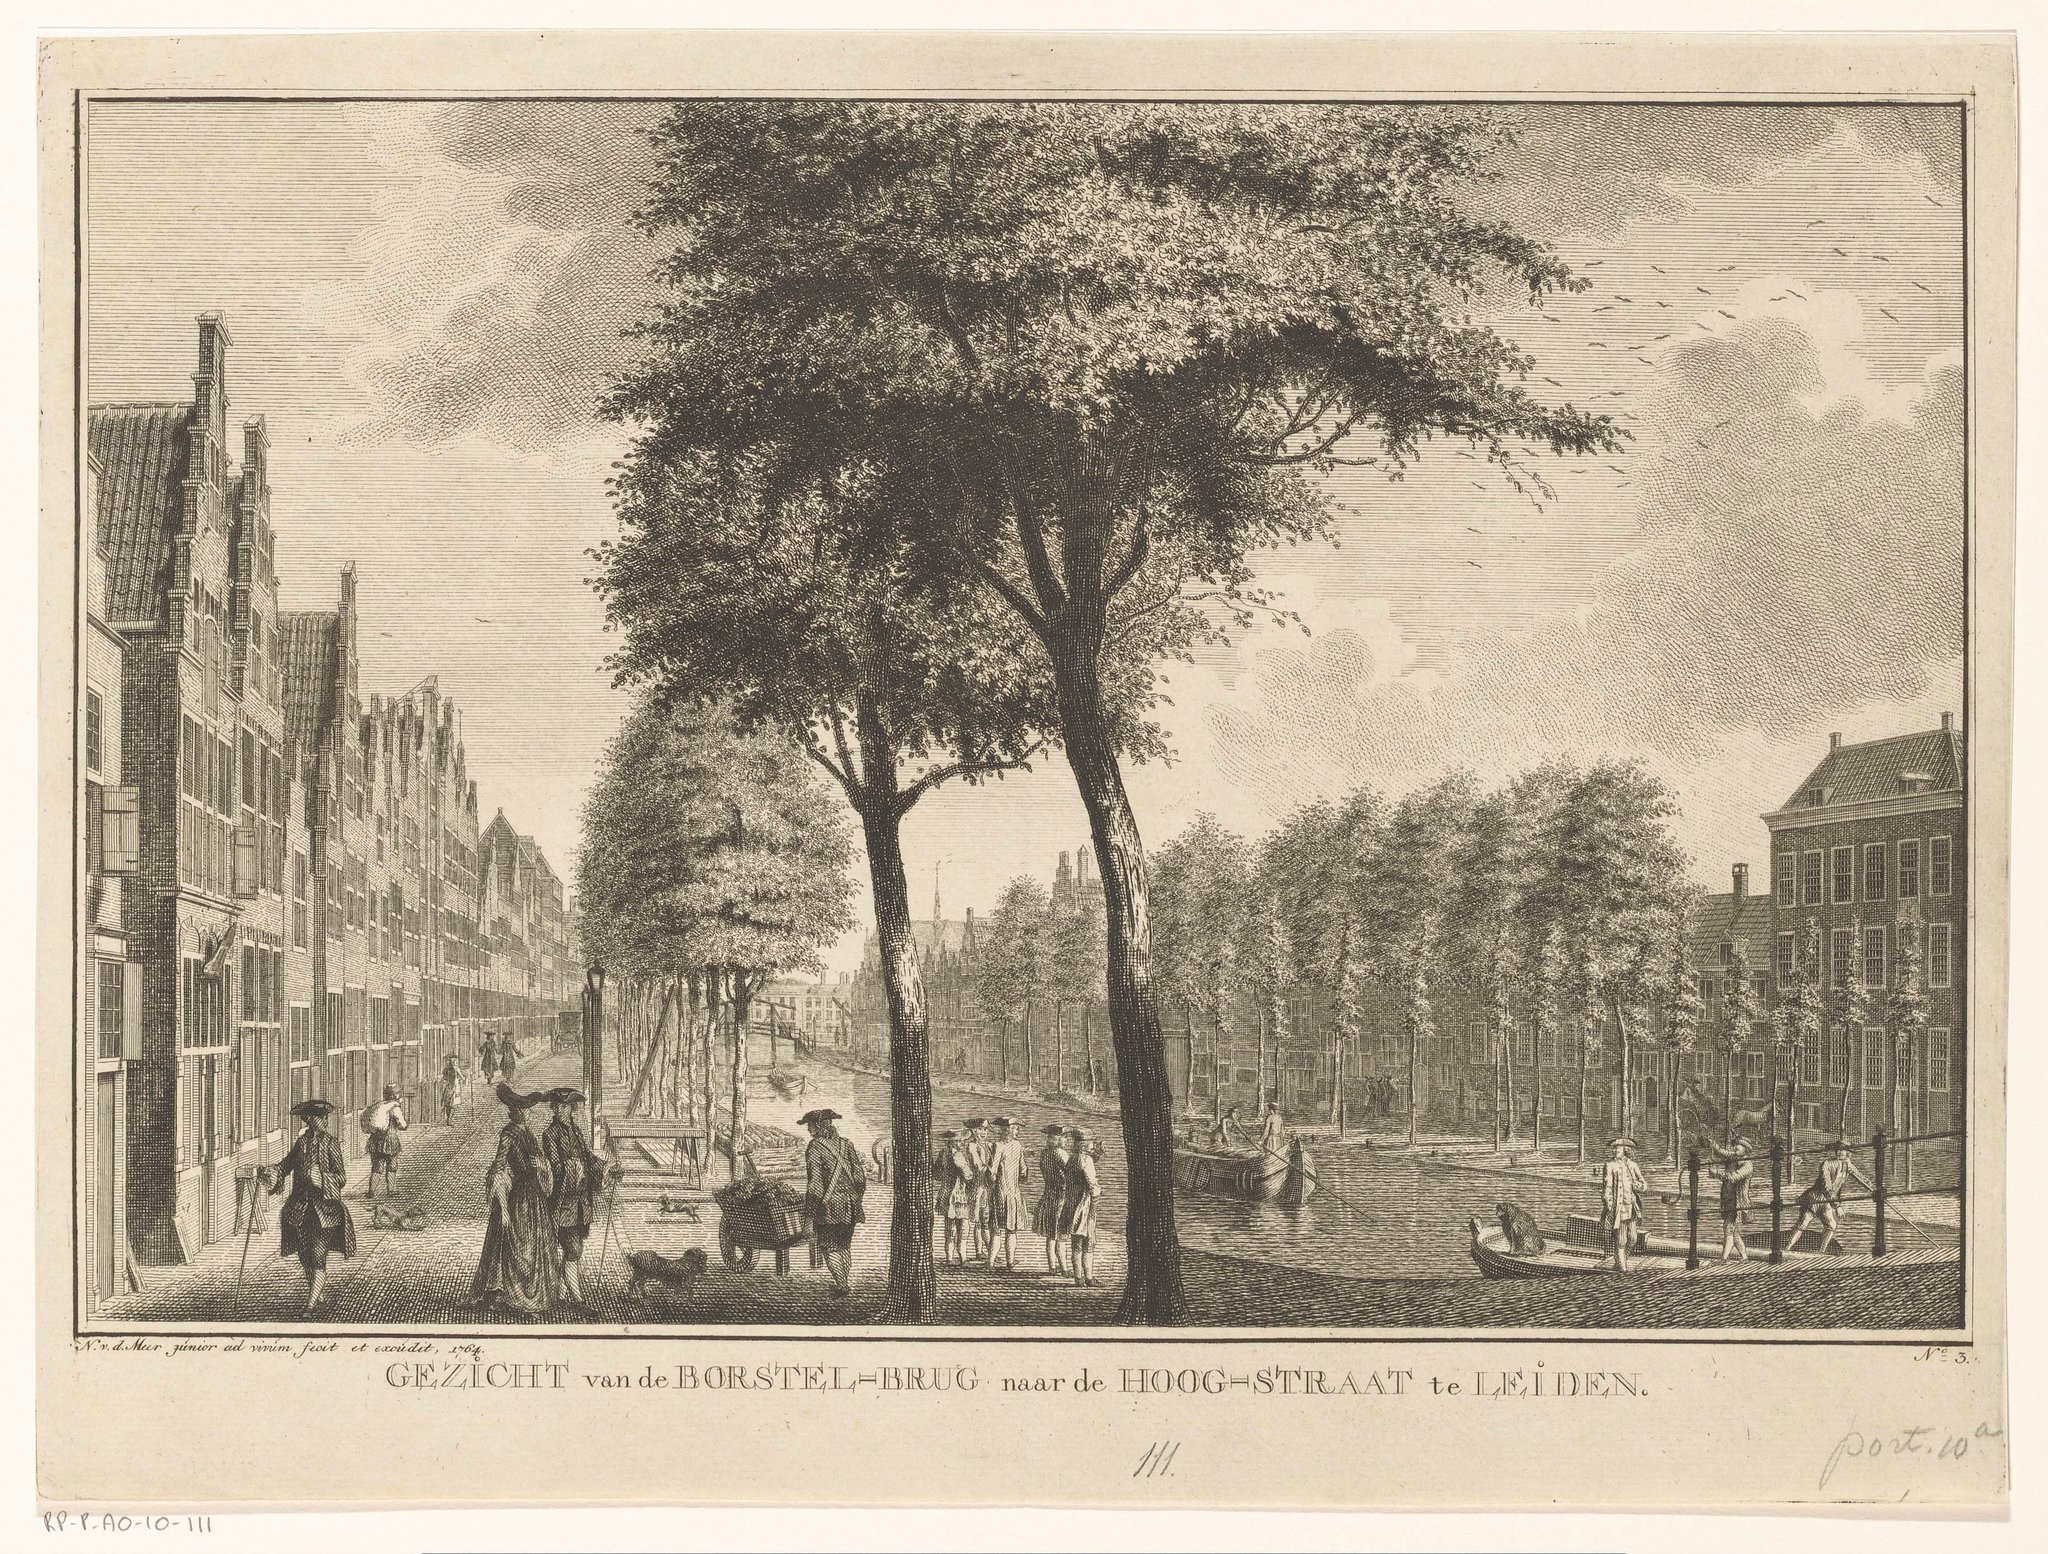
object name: print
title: Gezicht van de Borstelbrug naar de Hoogstraat te Leiden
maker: noach van der meer (ii)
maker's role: draughtsman, print maker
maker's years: 1741-1822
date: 1764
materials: paper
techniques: engraving, etching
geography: leiden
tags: poling, punting, wheelbarrow, quay, leiden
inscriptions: date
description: Gezicht vanaf de Borstelbrug naar de Hoogstraat te Leiden. Op de kade wandelaars en een man met een kruiwagen. Enkele mannen kijken naar een schuit, die langs vaart. Rechtsonder genummerd: 3.